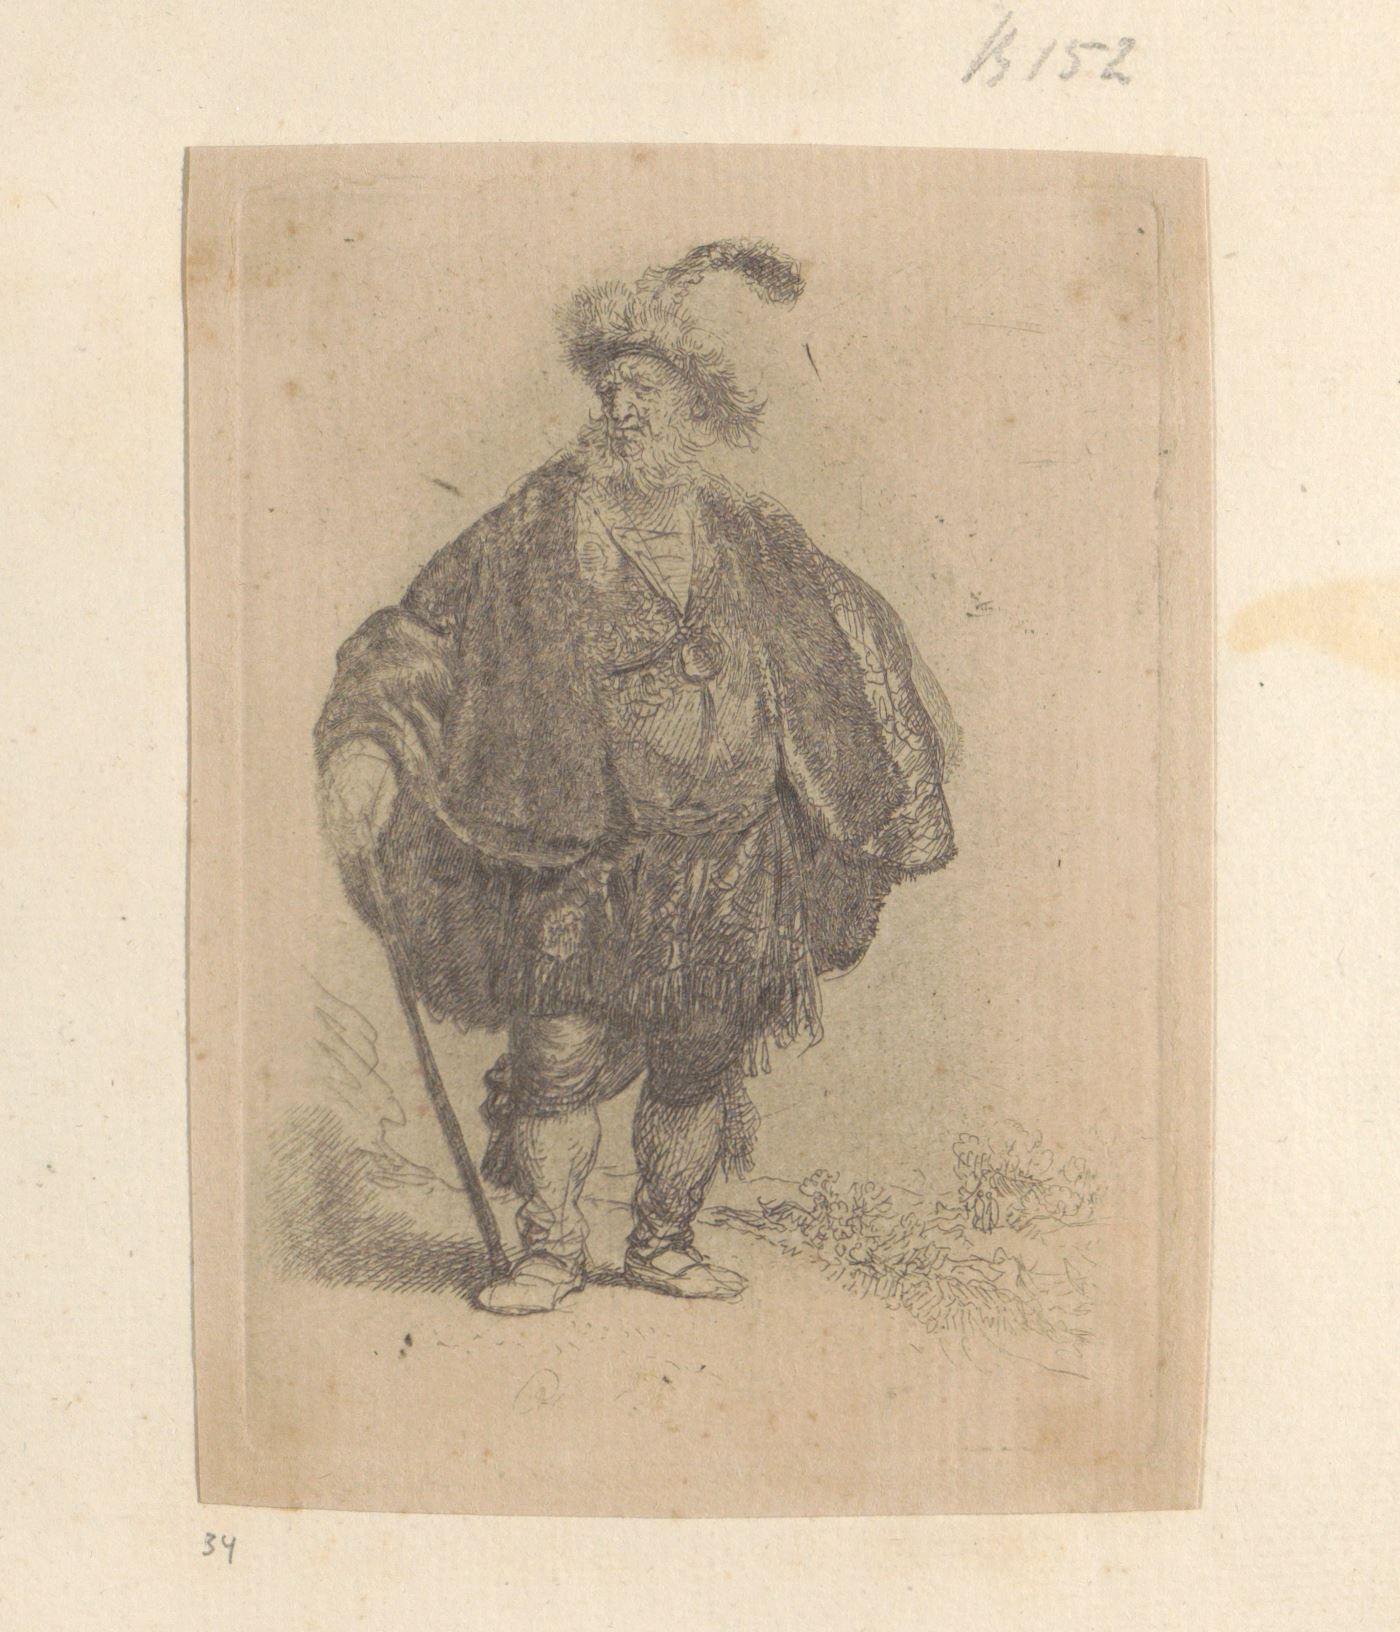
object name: album leaf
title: Recueil de quatre-vingt-cinq estampes originales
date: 1632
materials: paper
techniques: etching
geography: paris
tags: standing figure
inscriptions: date